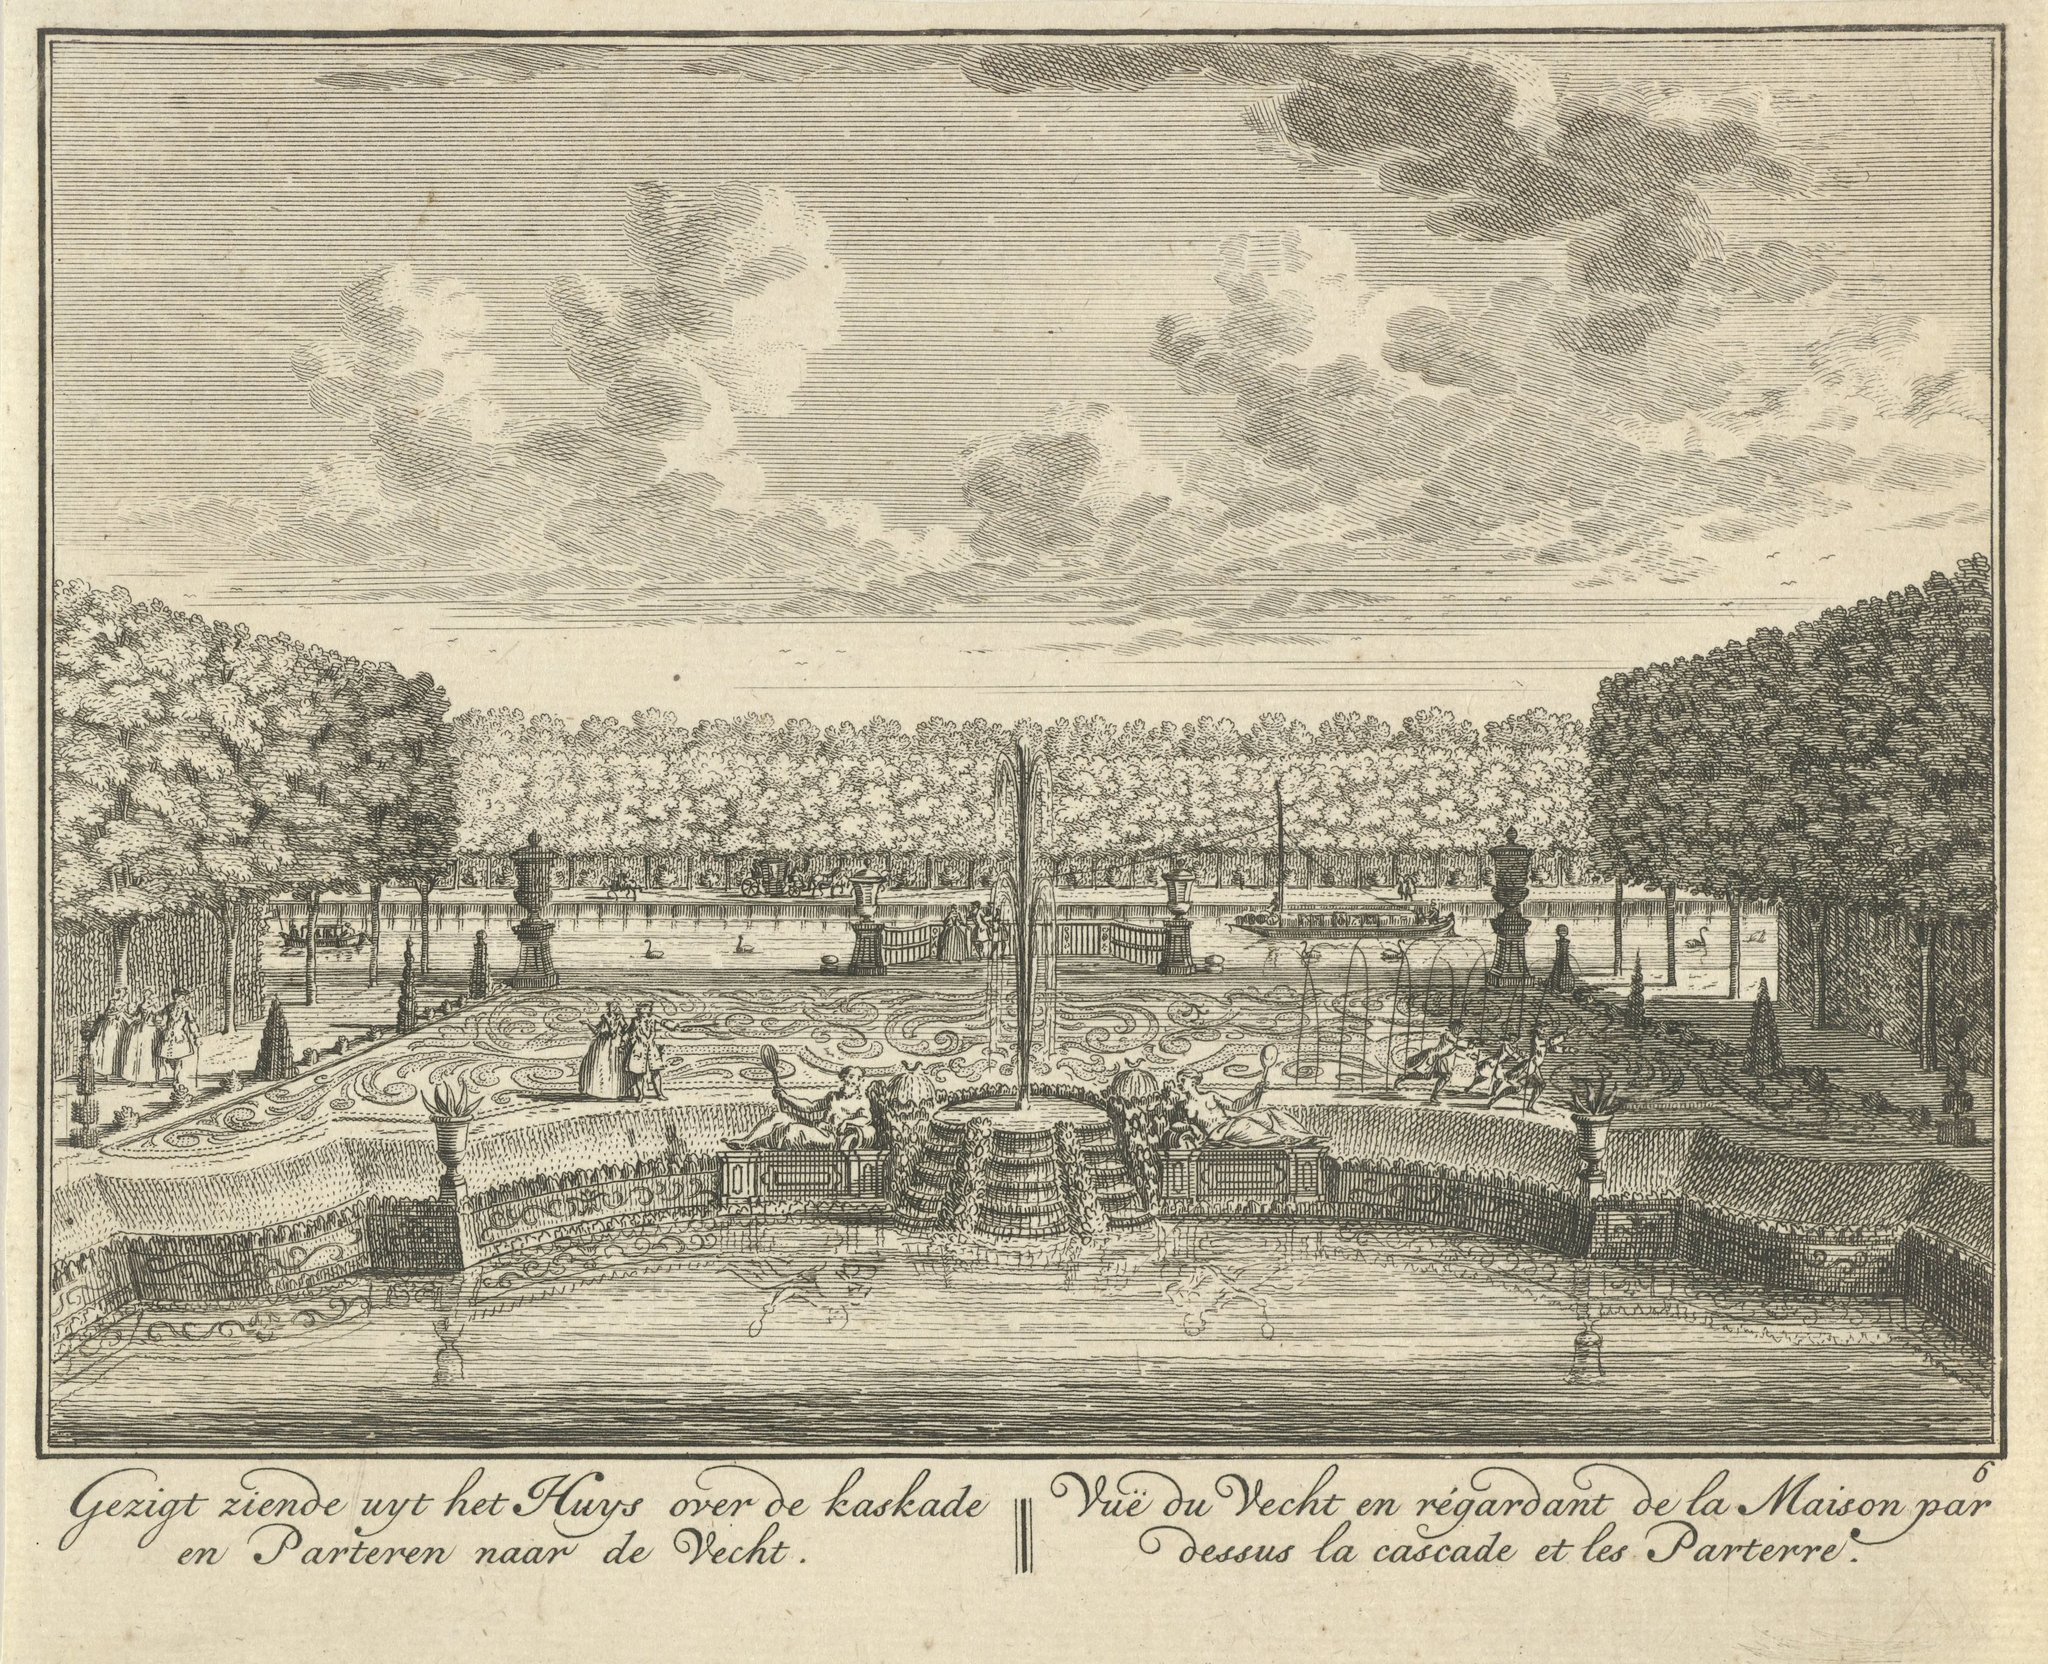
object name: print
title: Gezigt ziende uyt het huys over de kaskade en Parteren naar de Vecht / Vue du Vecht en régardant de la Maison par dessus la cascade et les Parterre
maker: hendrik de leth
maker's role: draughtsman, print maker, publisher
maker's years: 1703-1766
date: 1740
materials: paper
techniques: etching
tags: french or architectonic garden; formal garden, country-house, garden cascade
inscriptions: collector's mark: Lugt 2228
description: Gezicht op de symmetrisch aangelegde vijver met fontein in de Franse tuin van Huis ter Meer. De prent maakt deel uit van een serie met 26 gezichten op Huis ter Meer en het bijbehorende landgoed te Maarssen.